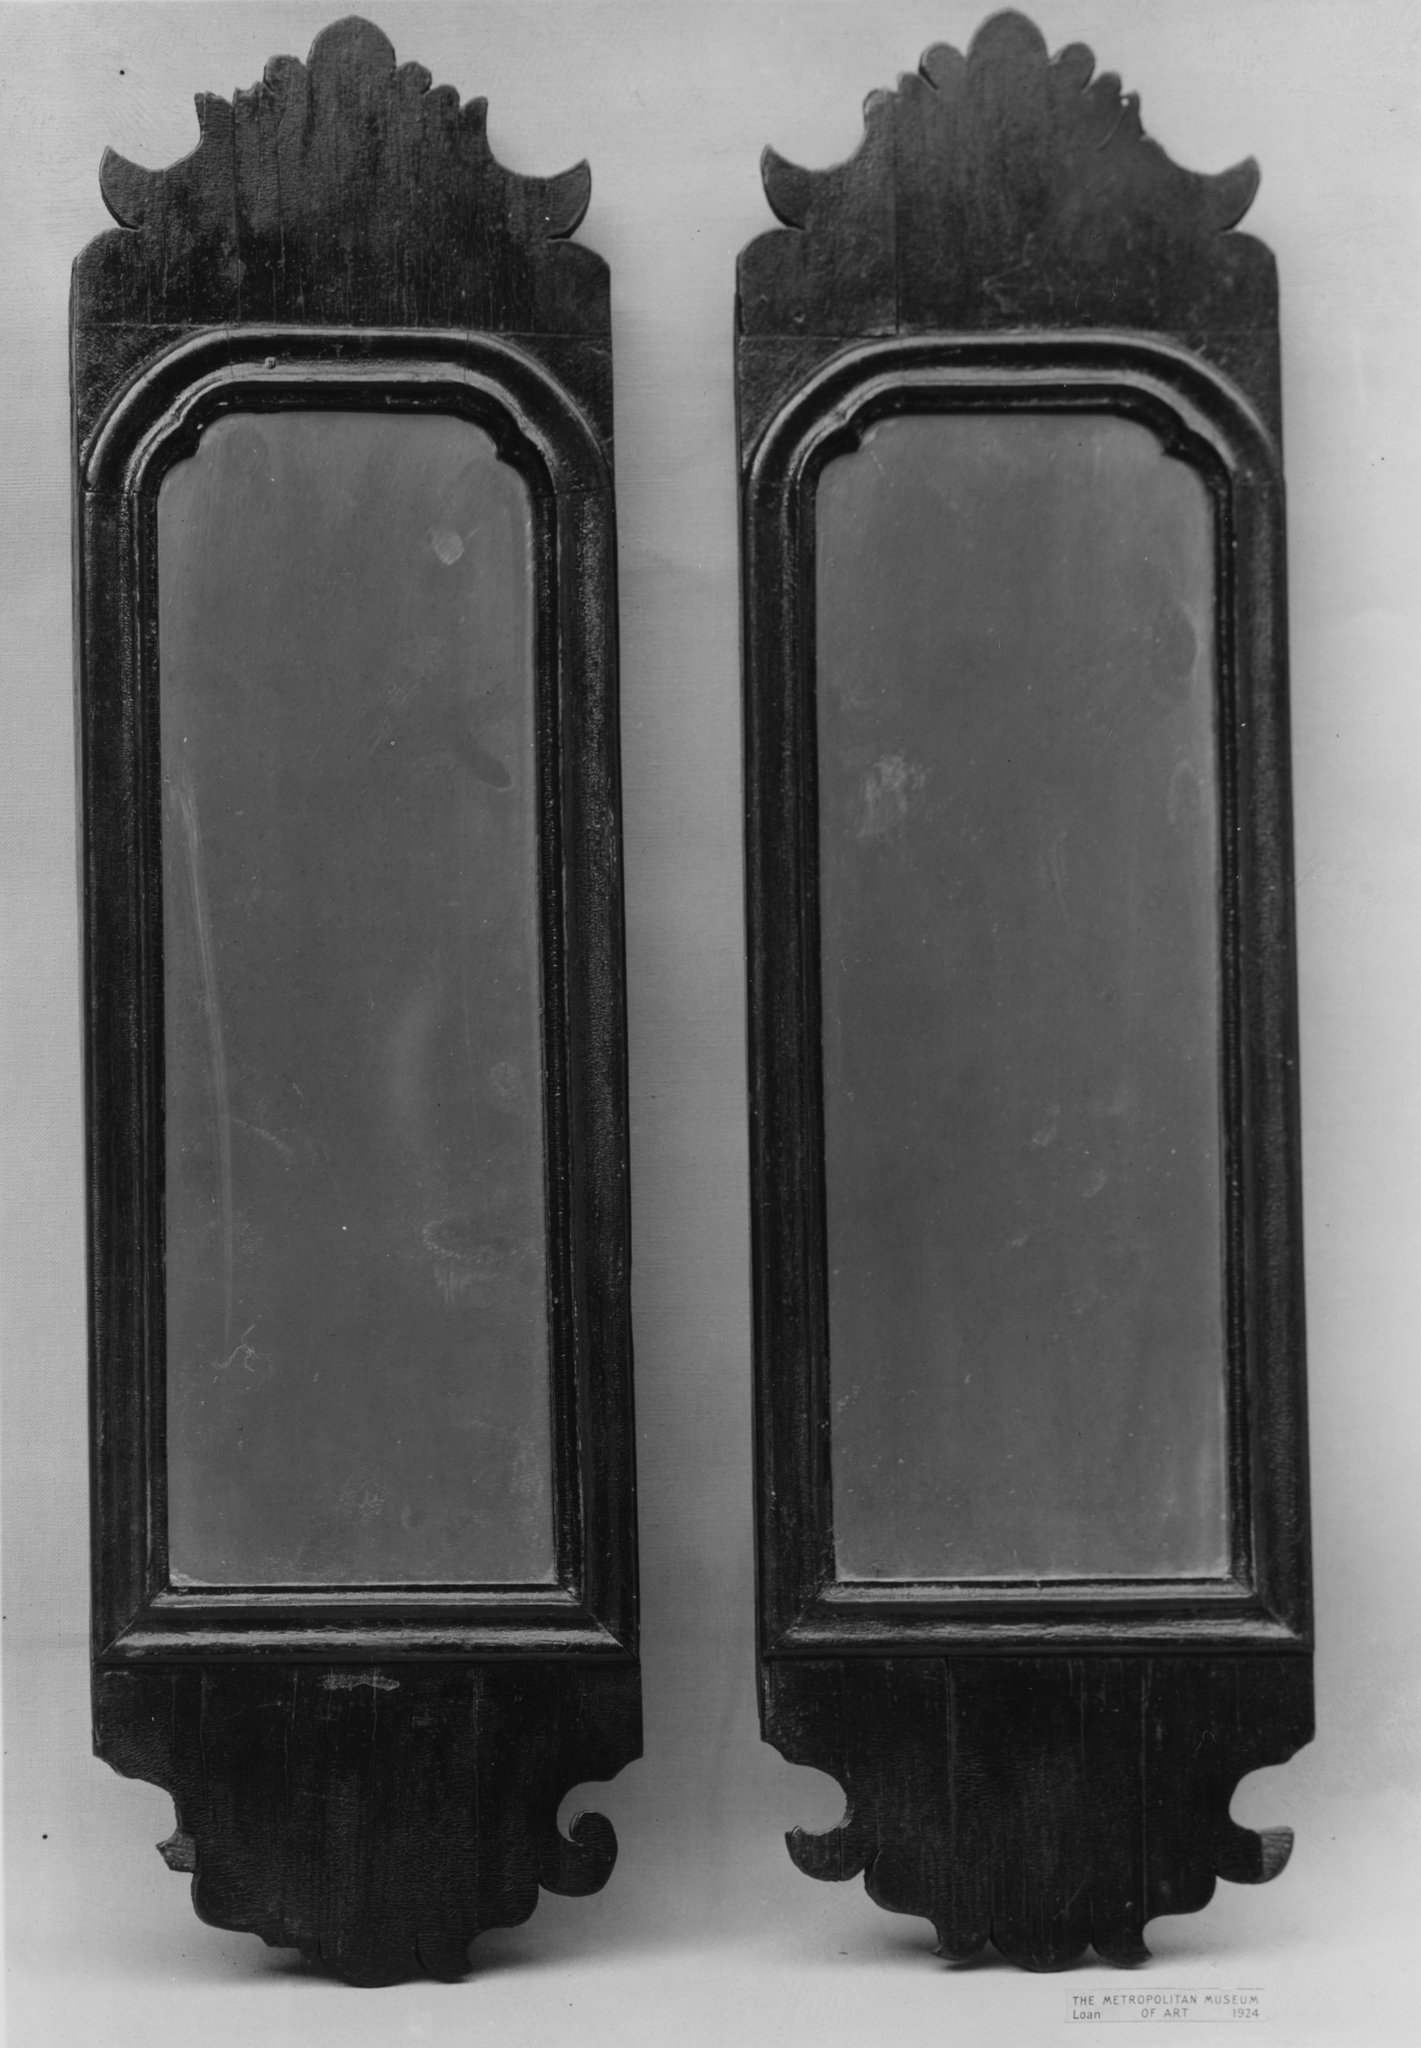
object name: looking glass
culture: american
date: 1740-1790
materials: wood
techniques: veneering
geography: united states